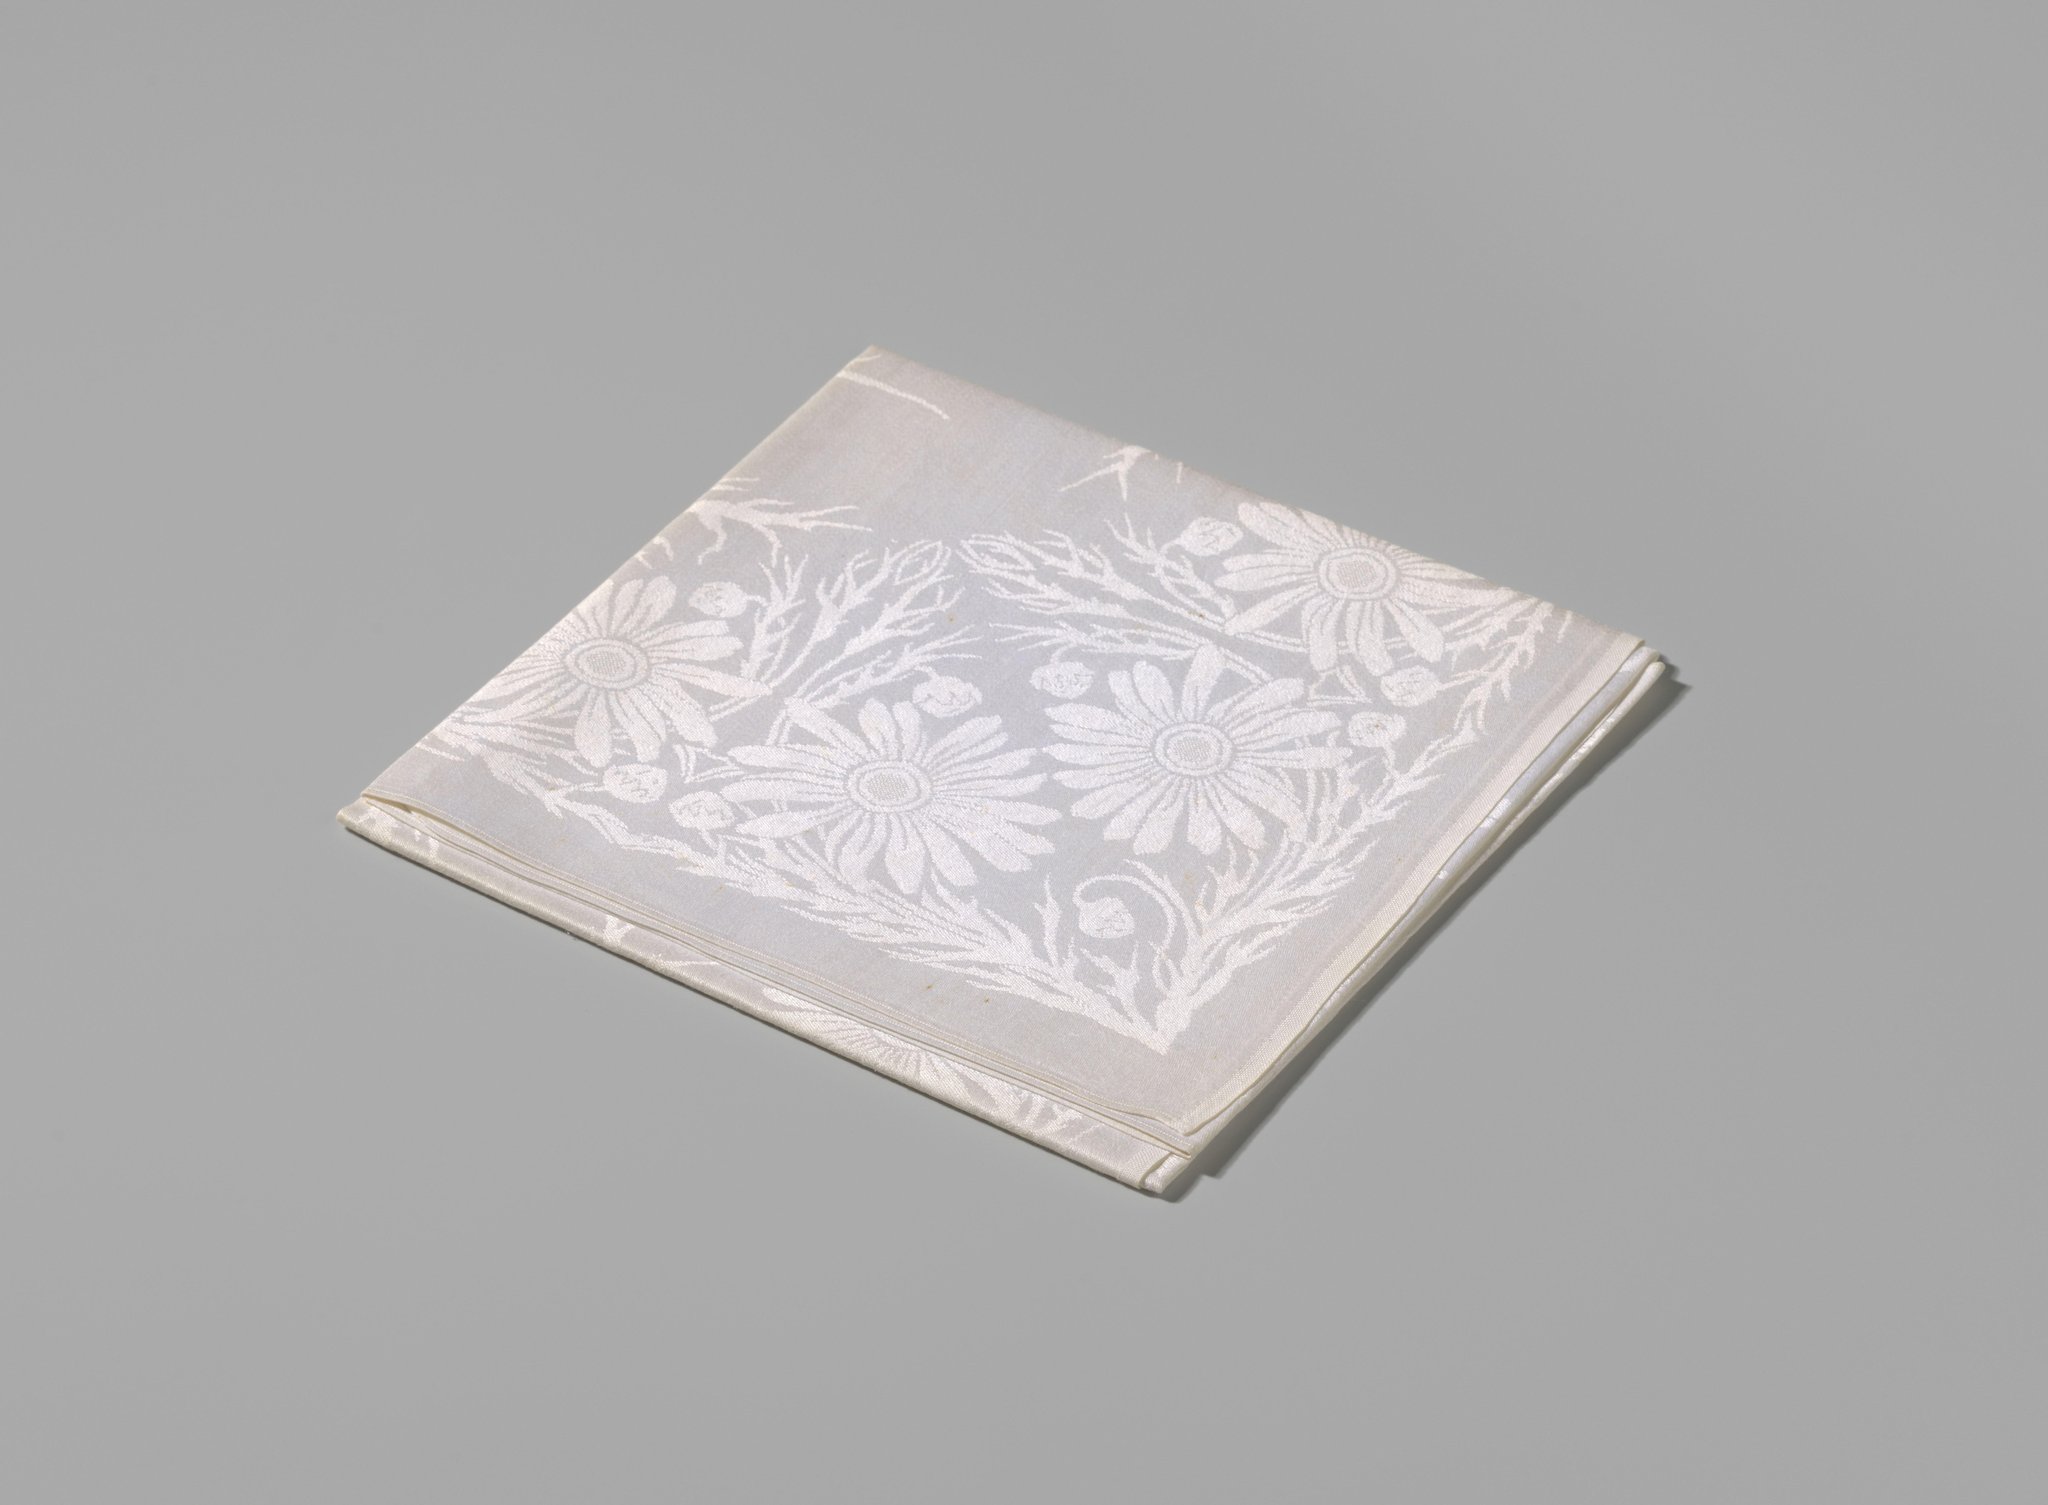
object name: napkin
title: Servet van linnendamast met dessin Marguerite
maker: cornelis van der sluys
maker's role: print maker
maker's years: 1881-1944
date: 1904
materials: linen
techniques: damask, weave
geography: eindhoven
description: Servet van linnendamast met een bloempatroon: motief Marguerite, dessin nr. 500. Het servet hoort bij twaalf servetten, twaalf vingerdoeken en een tafellaken.